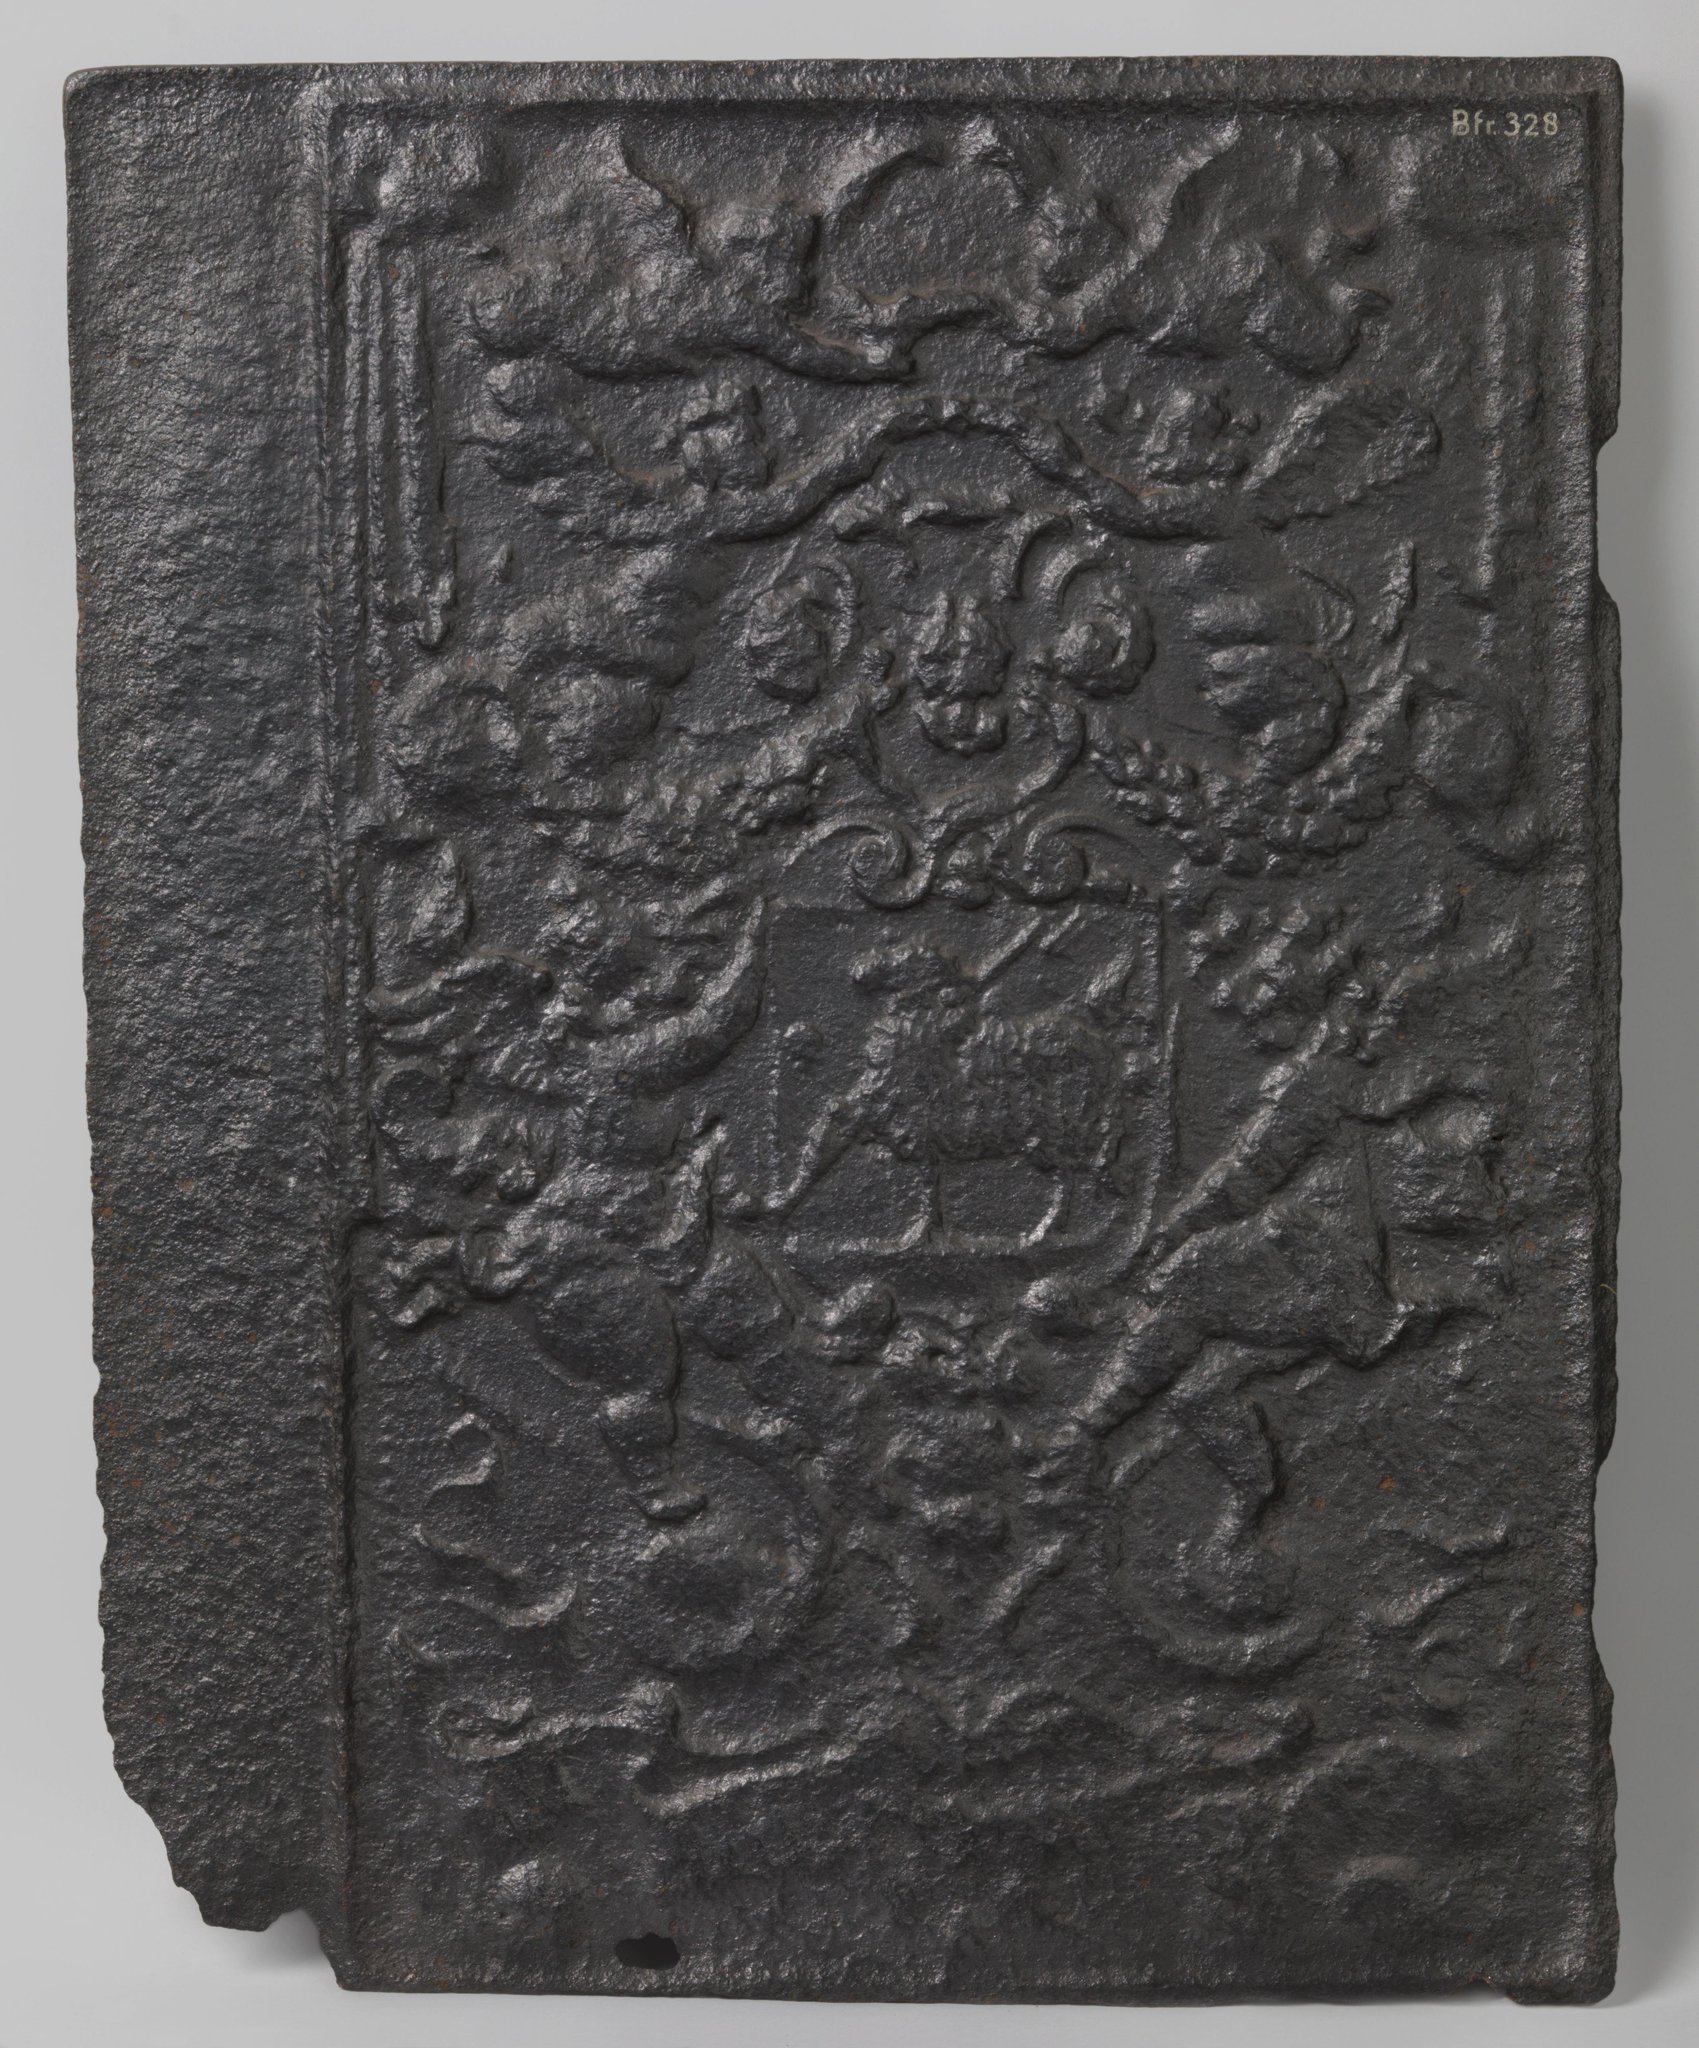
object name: stove plate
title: Kachelplaat met het Lam Gods op een wapenschild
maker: Anonymous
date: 1650-1700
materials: iron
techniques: casting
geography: germany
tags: lamb bearing cross or banner, 'agnus dei' ~ symbol of christ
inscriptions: inscription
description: Kachelplaat van gietijzer. Centraal staat in een wapenschild het Lam Gods met de kop naar links. Het wapenschild wordt gedragen door twee putti. Direct daarboven nog vier vliegende putti, met tussen hen twee guirlandes, twee kransen en een maskaron. Direct onder het tafereel een banderol met tekst.